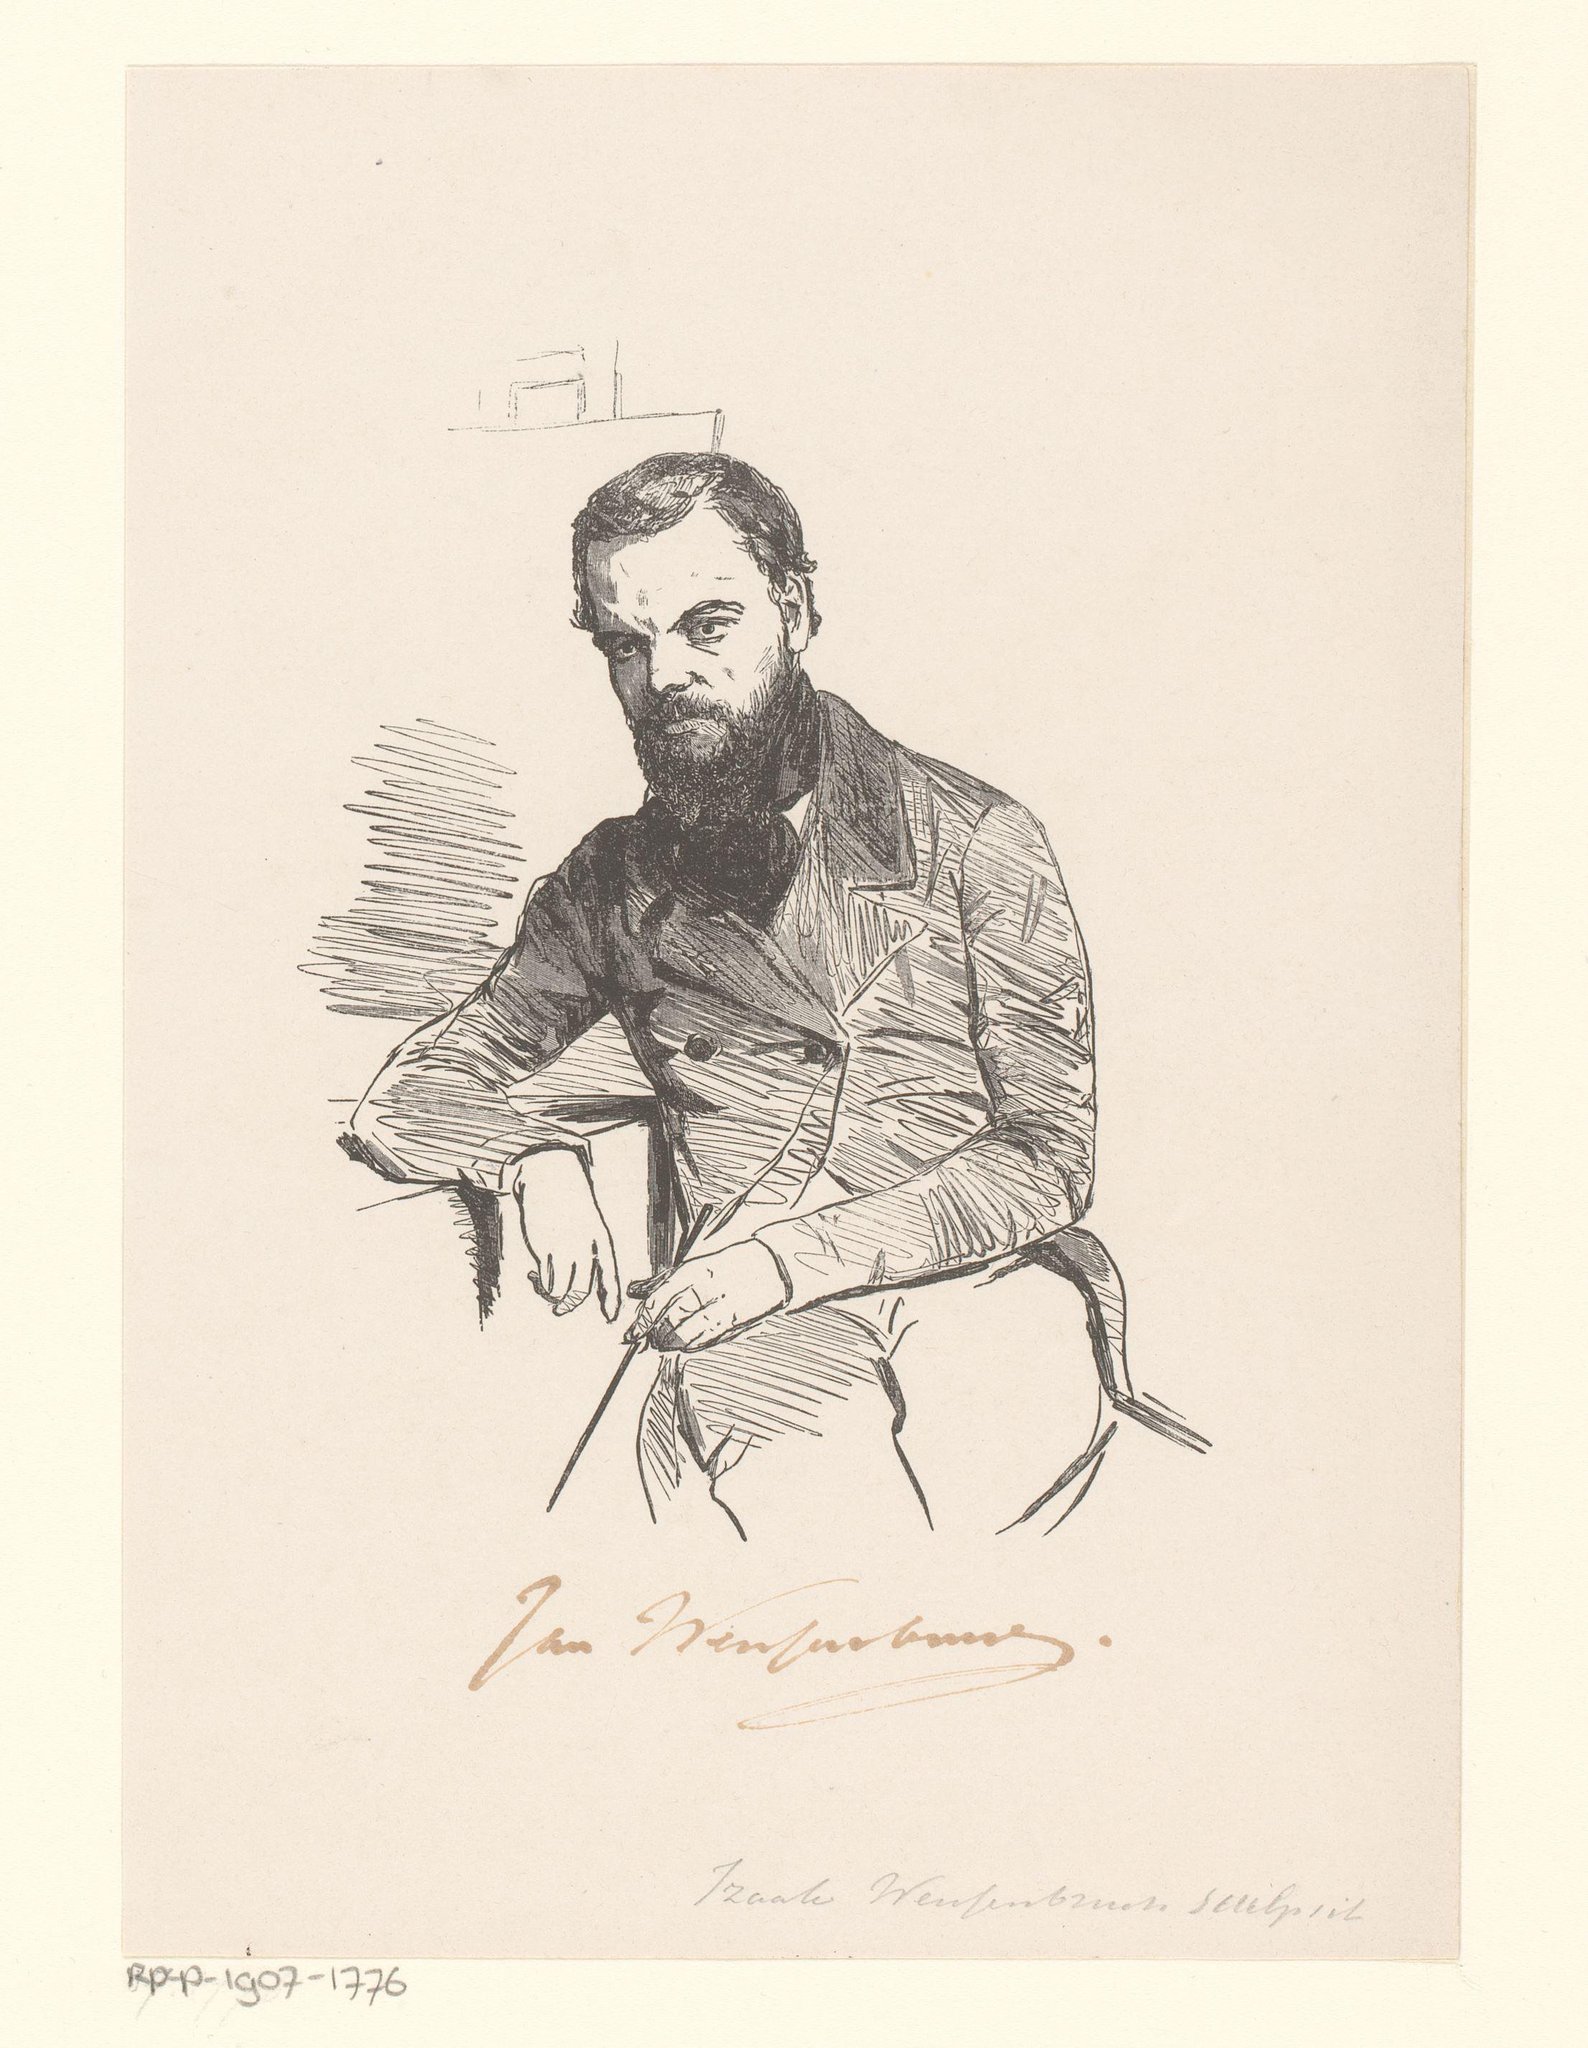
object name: print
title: Portret van Jan Weissenbruch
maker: isaac weissenbruch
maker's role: print maker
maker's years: 1826-1912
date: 1840-1907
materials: paper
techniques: engraving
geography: netherlands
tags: the hague, painter, print maker, jan weissenbruch, portrait, self-portrait of artist